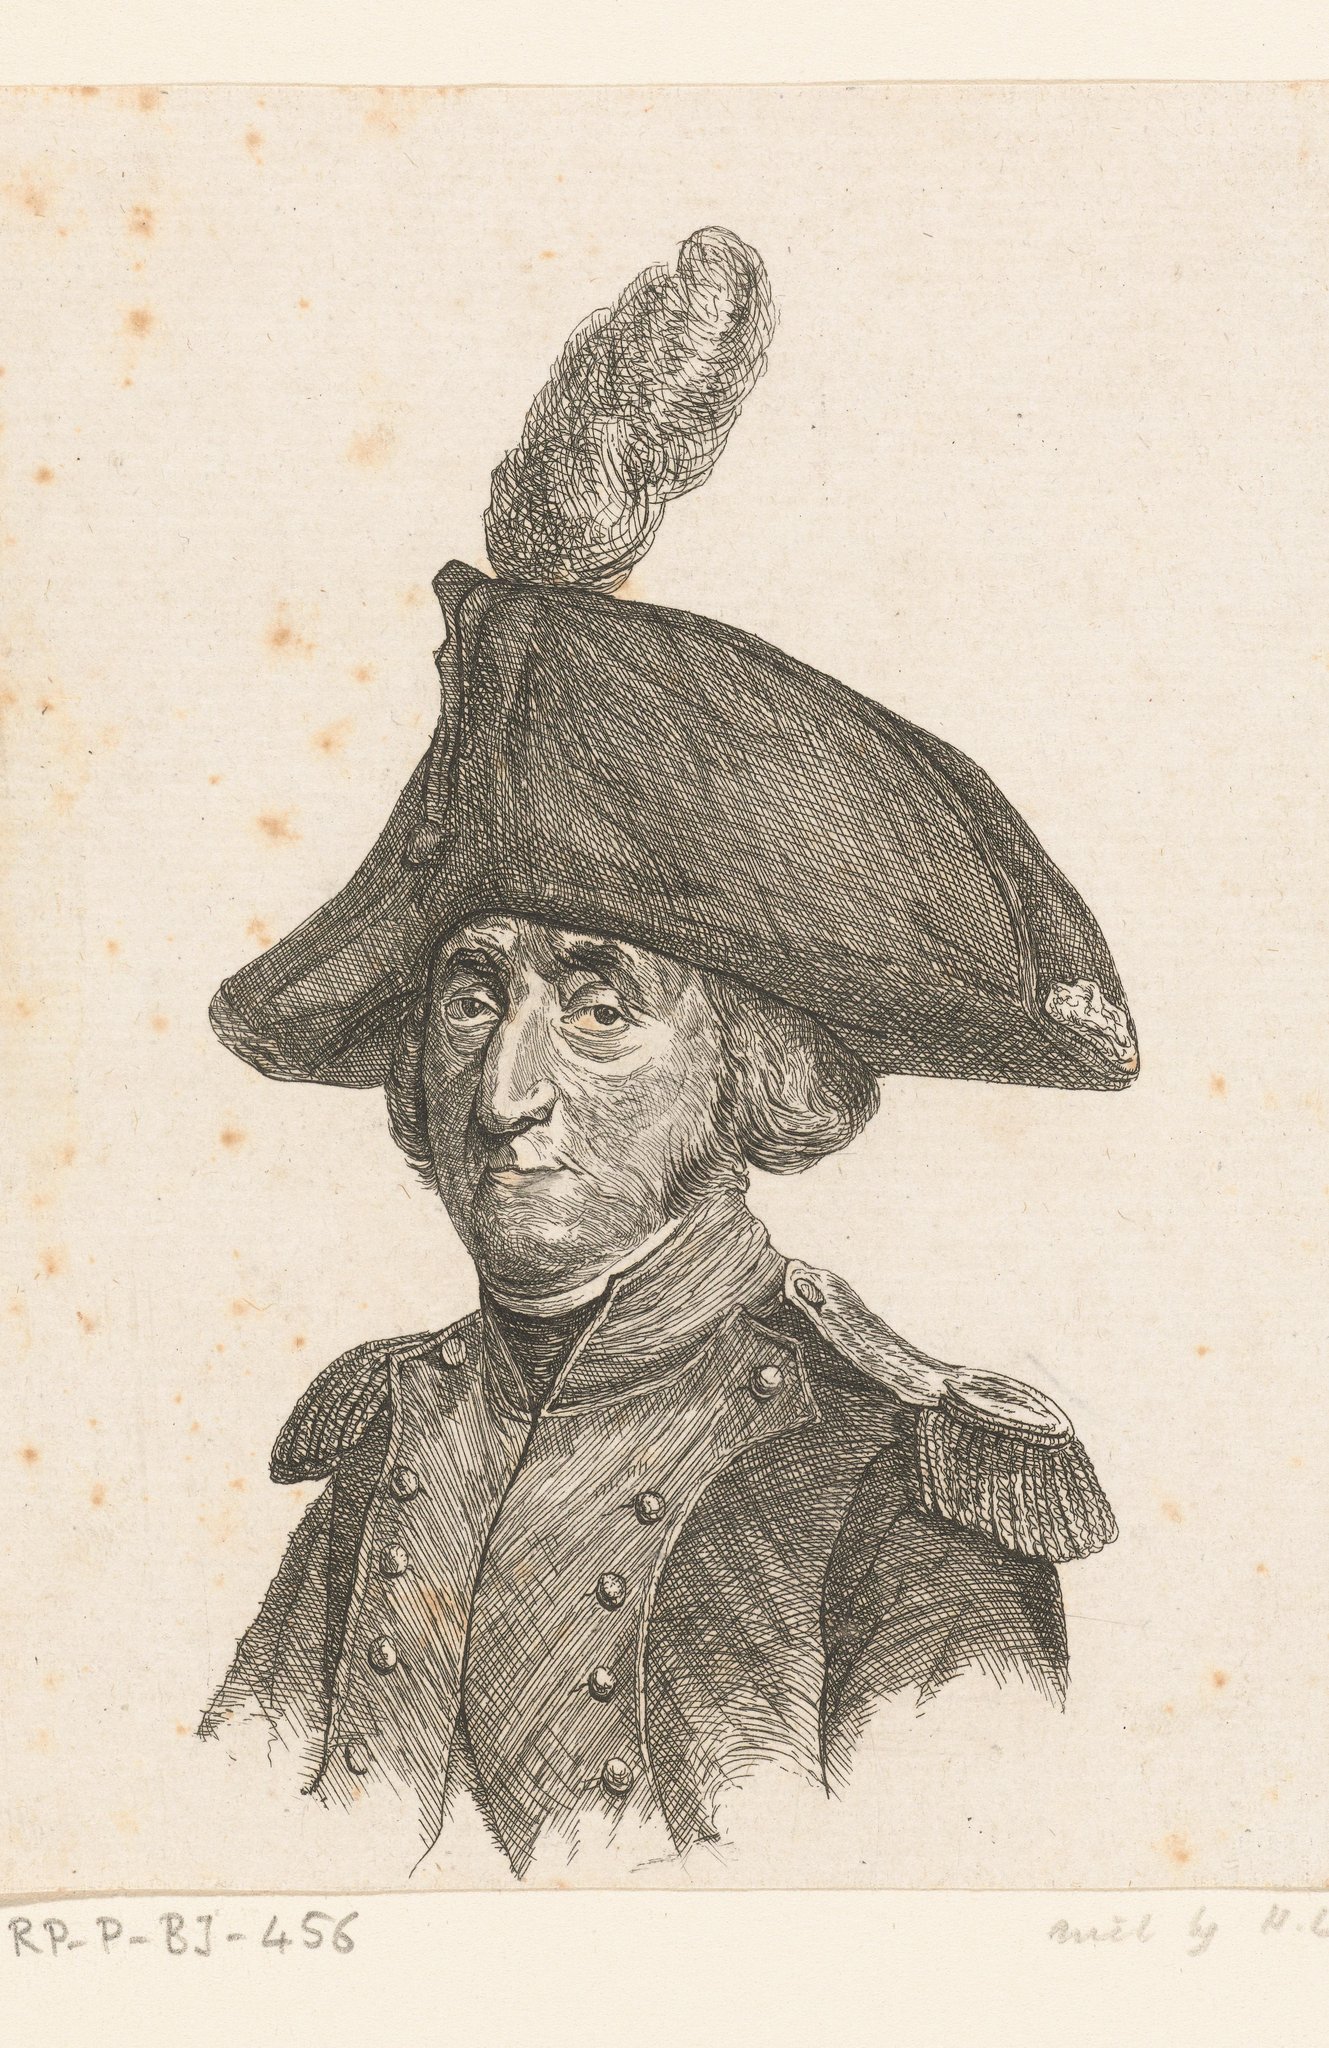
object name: print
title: Portret van luitenant-kolonel Benjamin Roelofswaard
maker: ernst willem jan bagelaar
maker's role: draughtsman, print maker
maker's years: 1775-1837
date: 1798-1837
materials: paper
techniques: etching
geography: netherlands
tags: kapitein, benjamin roelofswaard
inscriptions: collector's mark: Lugt 2228, inscription: ‘De Commandant van den Luitt. Bagelaar’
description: Portretbuste naar links, met uniform en steek met opstaande pluim.